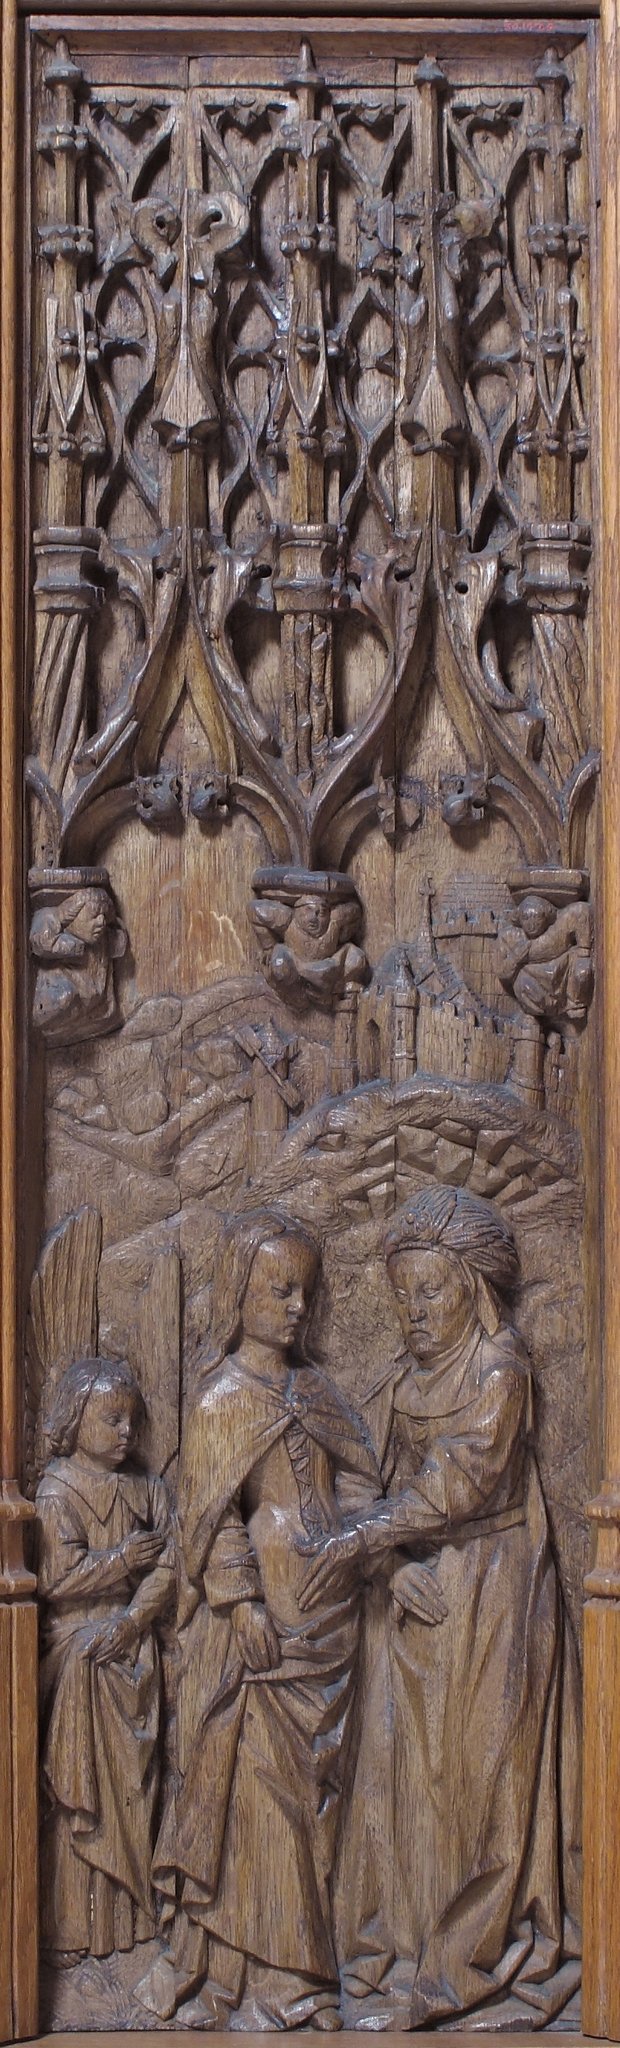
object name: panel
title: Panel with the Visitation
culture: french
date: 1501-1533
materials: wood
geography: france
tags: men,women